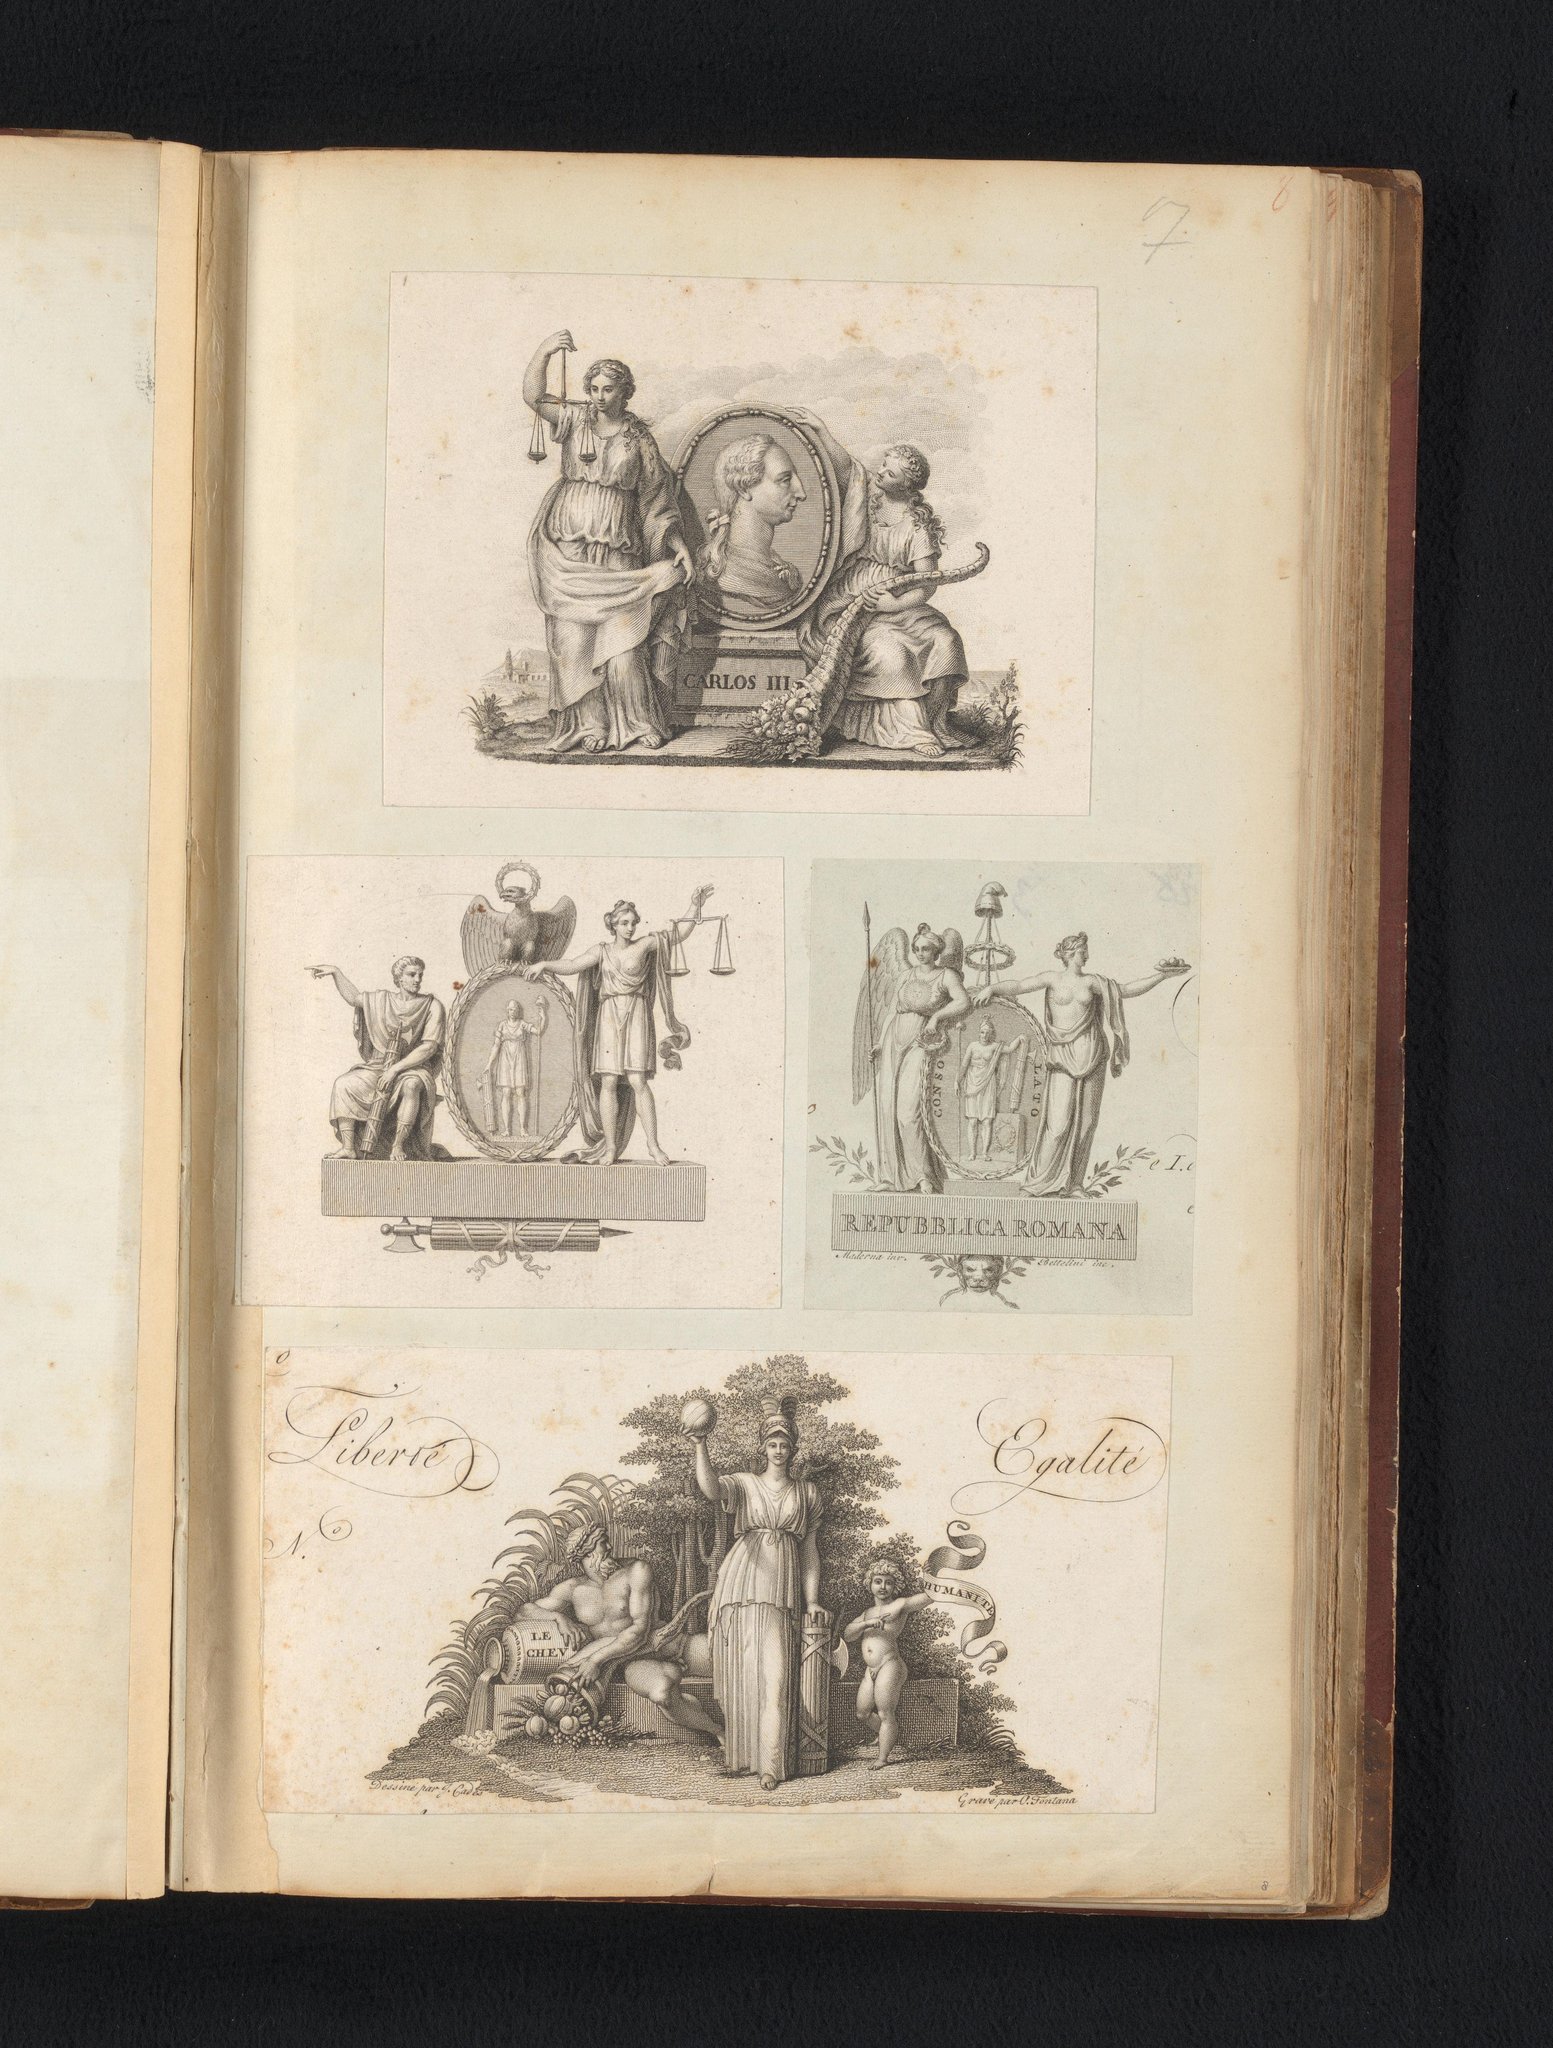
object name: print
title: Allegorische vignetten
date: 1750-1816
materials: paper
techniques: engraving, etching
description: Vier vignetten met verschillende allgorische figuren. Onderdeel van het tweede van twee albums met ingeplakte prenten en tekeningen te dienen als tekenvoorbeelden.